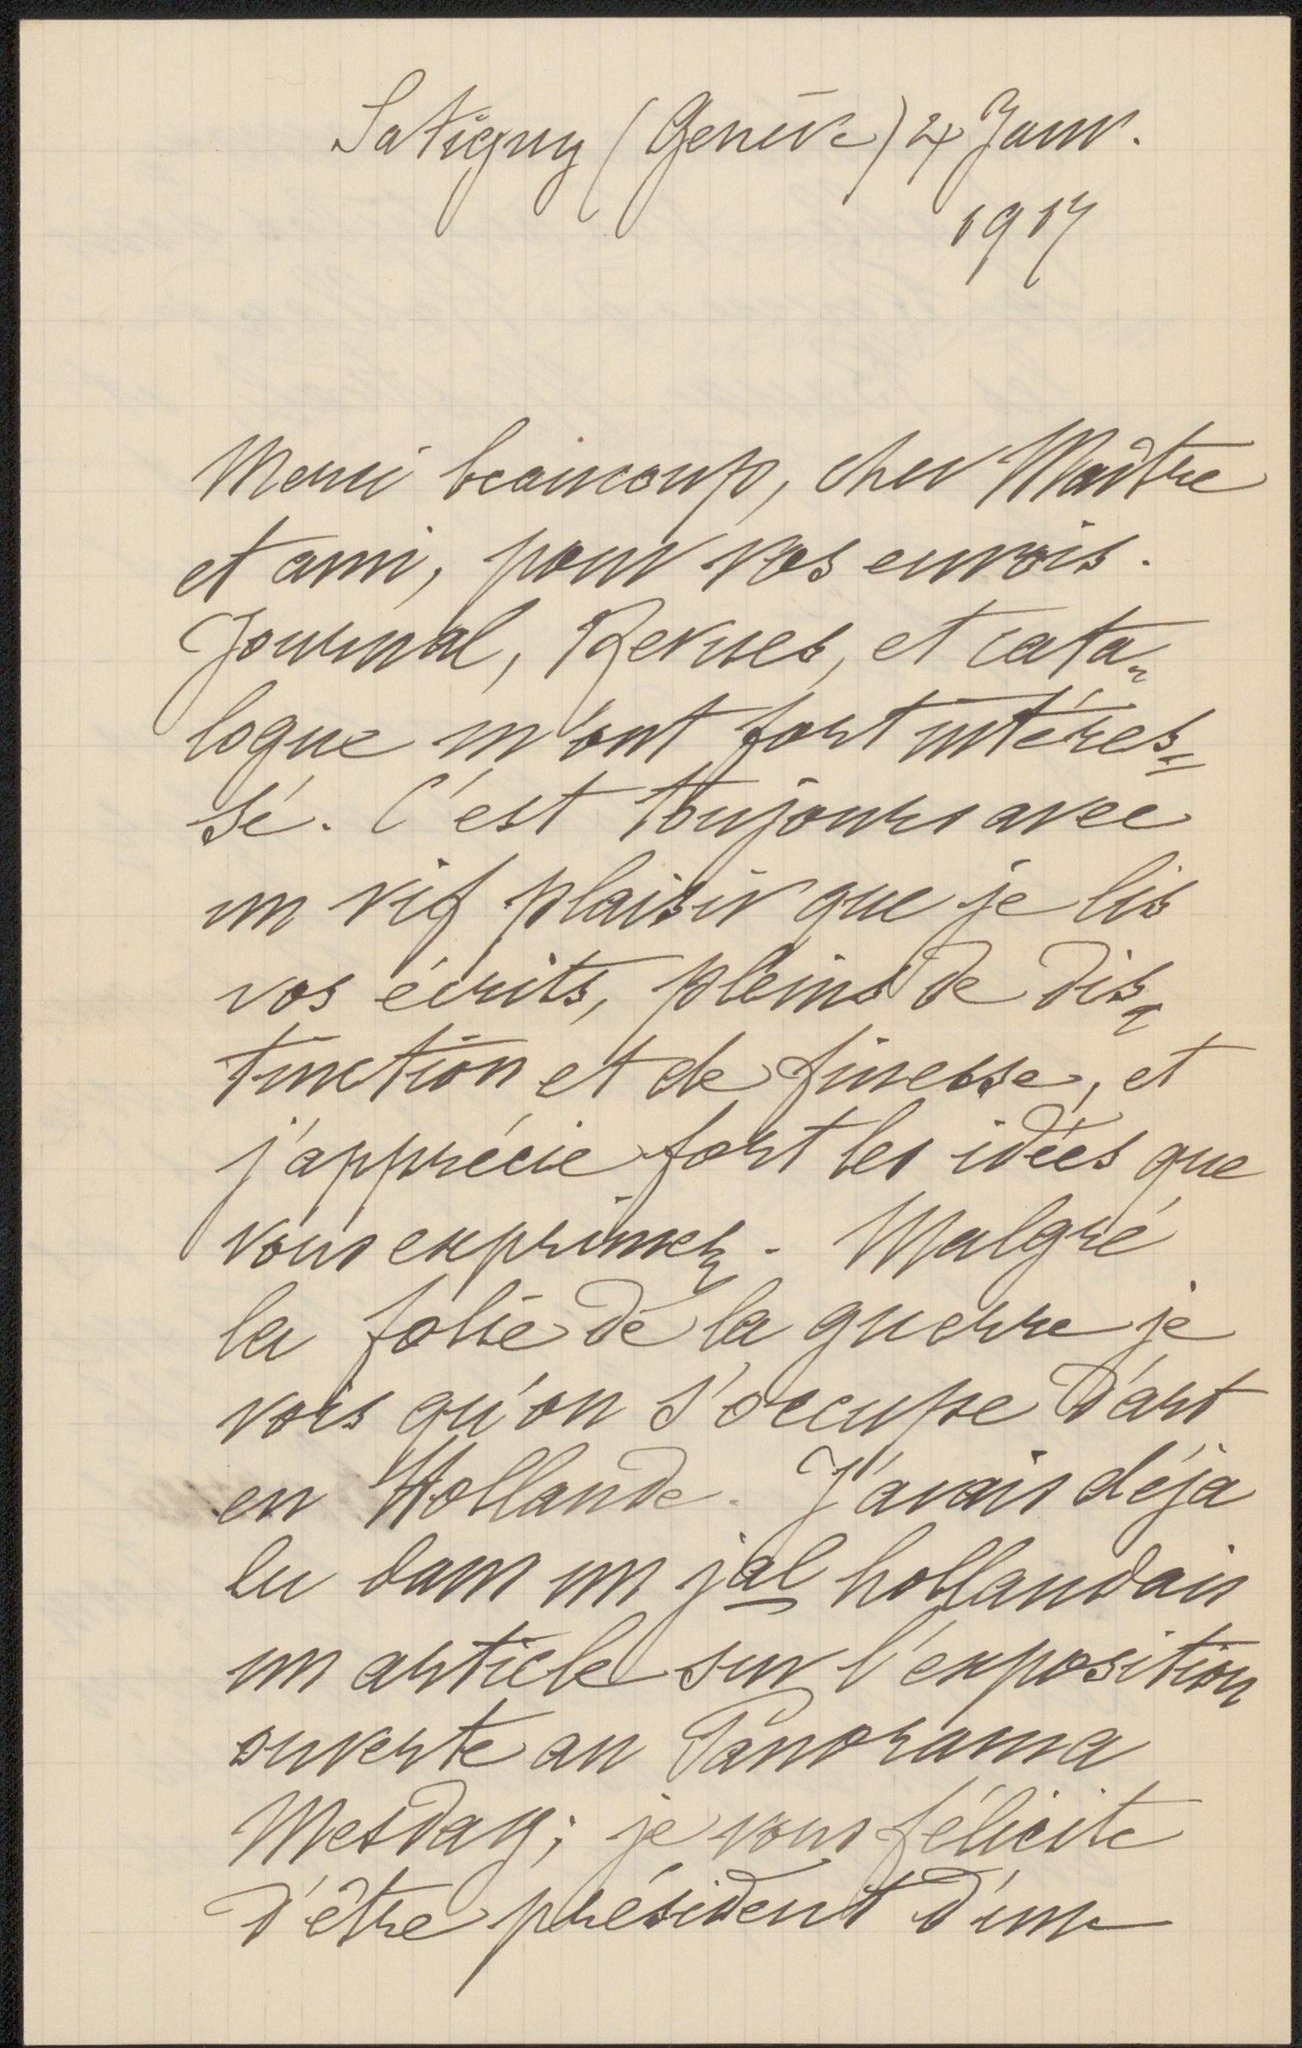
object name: letter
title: Brief aan Philip Zilcken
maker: alphonse stengelin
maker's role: painter, print maker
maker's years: 1852-1938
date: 1917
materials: ink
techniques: pen, writing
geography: satigny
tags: johannes bosboom, the hague, amsterdam, print maker, draughtsman, marius bauer, arnhem, publisher, martinus nijhoff, gustave flaubert, frédéric mistral, philip zilcken, painting (including book-illumination, miniature-painting), exhibition ~ art, printed matter, netherlands, belgium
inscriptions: collector's mark: ‘RPK’